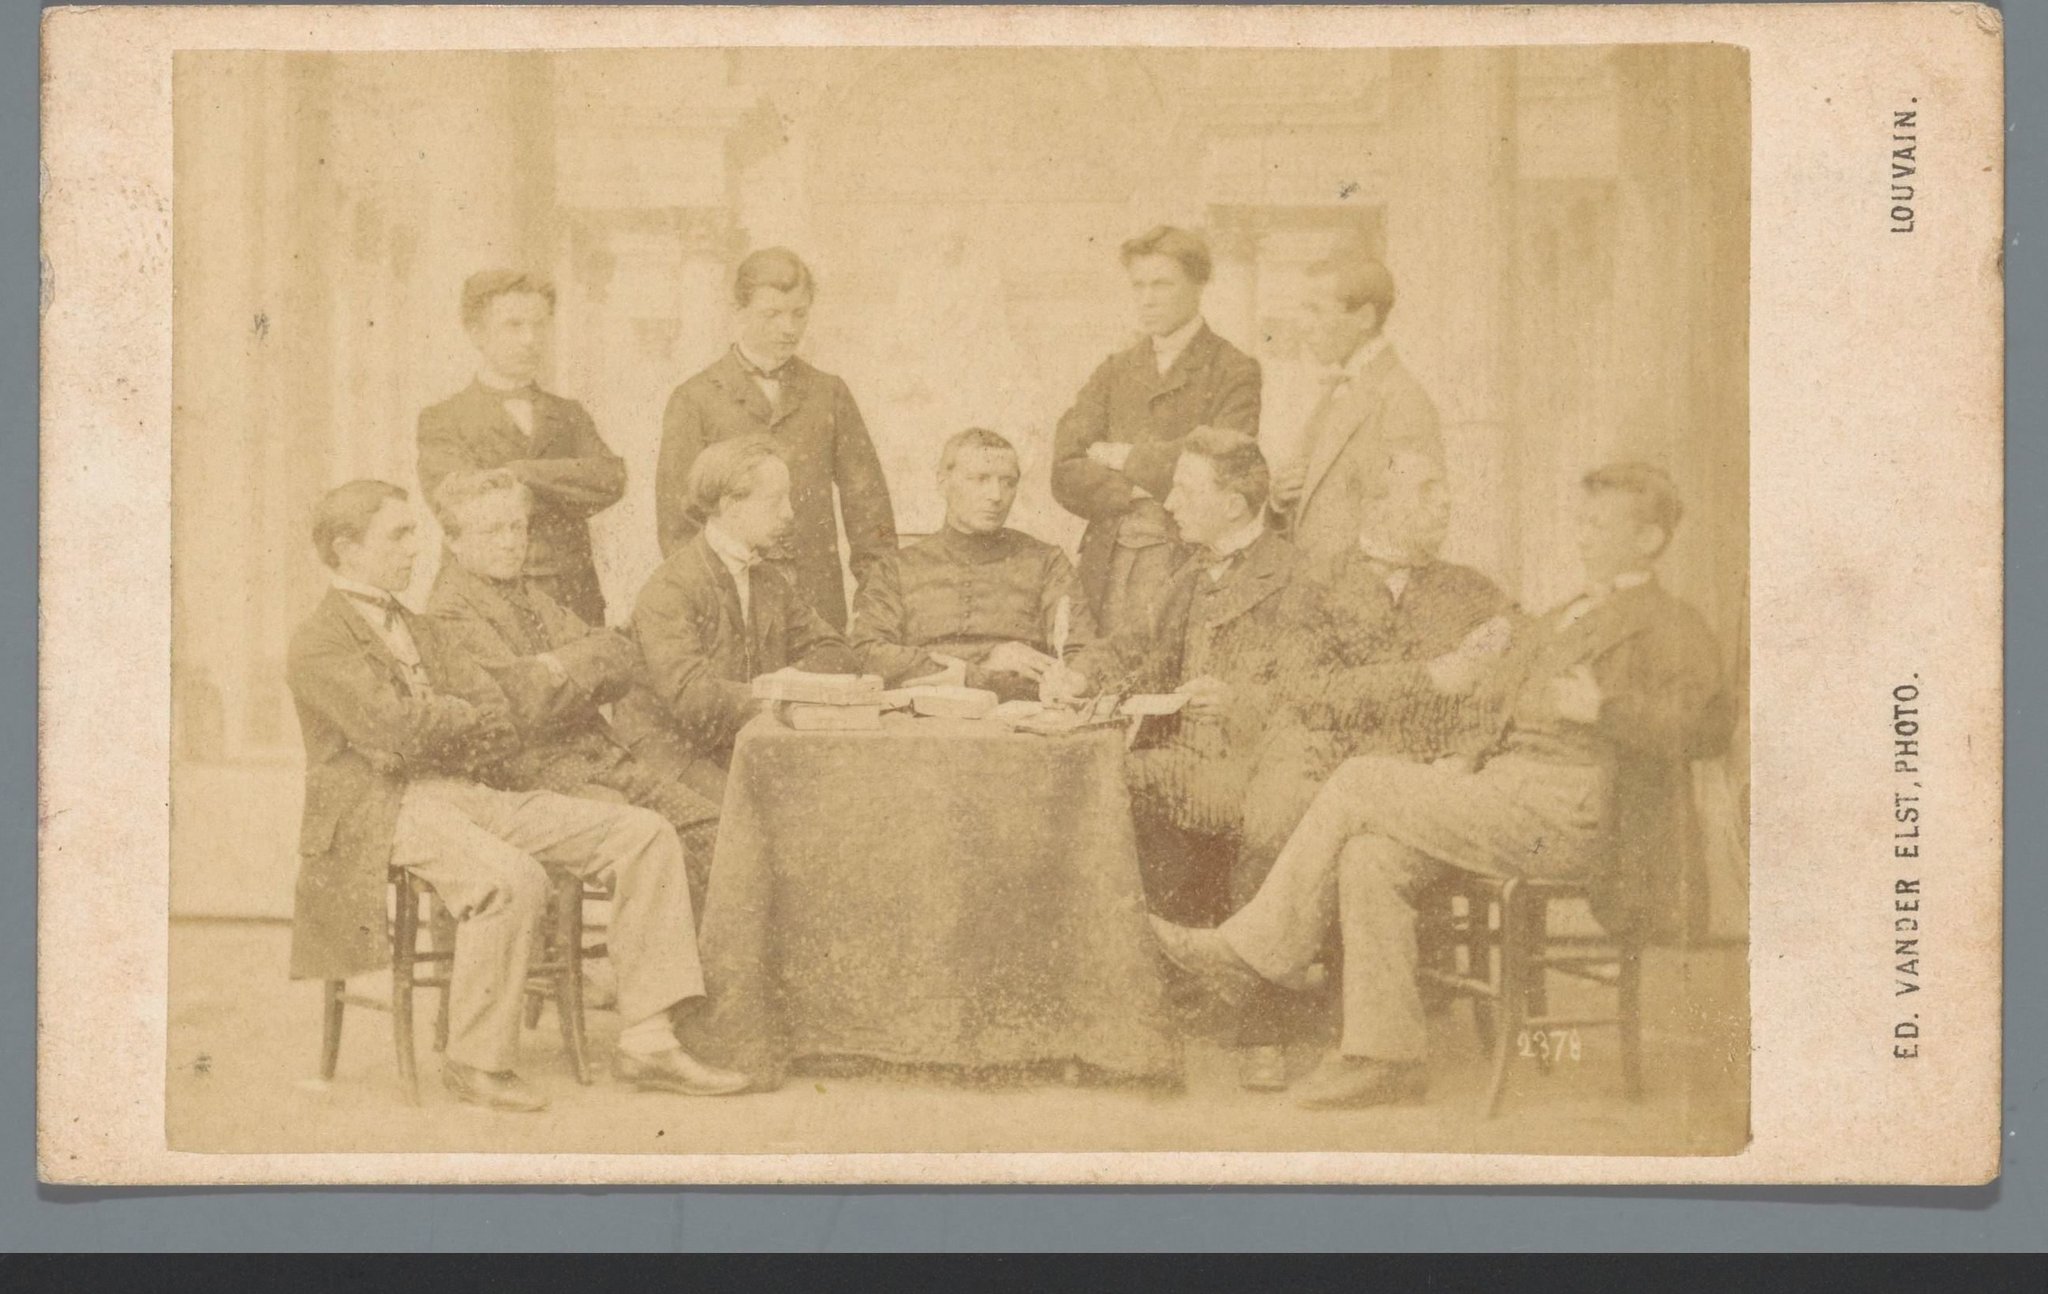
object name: photograph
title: Groepsportret van onbekende jongemannen en een onbekende geestelijke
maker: edouard van der elst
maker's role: fotograaf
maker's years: 1831-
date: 1860-1872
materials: cardboard, paper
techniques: albumen print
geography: leuven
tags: youth, adolescent, anonymous historical persons portrayed in a group, in a group-portrait, louvain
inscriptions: inscription: ‘Ed. vander Elst, phot. Louvain.’, inscription: ‘Mrs. Alphonse Verkaert, De Coen, Audeau,/ Le Clercq, Herremans, Struc-/ teur, Verrendiel, V. Melcke-/ bech.’, number: ‘2378’, inscription: ‘Photographie/ Edouard vander Elst/ Louvain/ 65, Rue Tirlemont/ Emtrée par la porte cochère/ Rappeler ce No 55 pour avoir le même portrait’